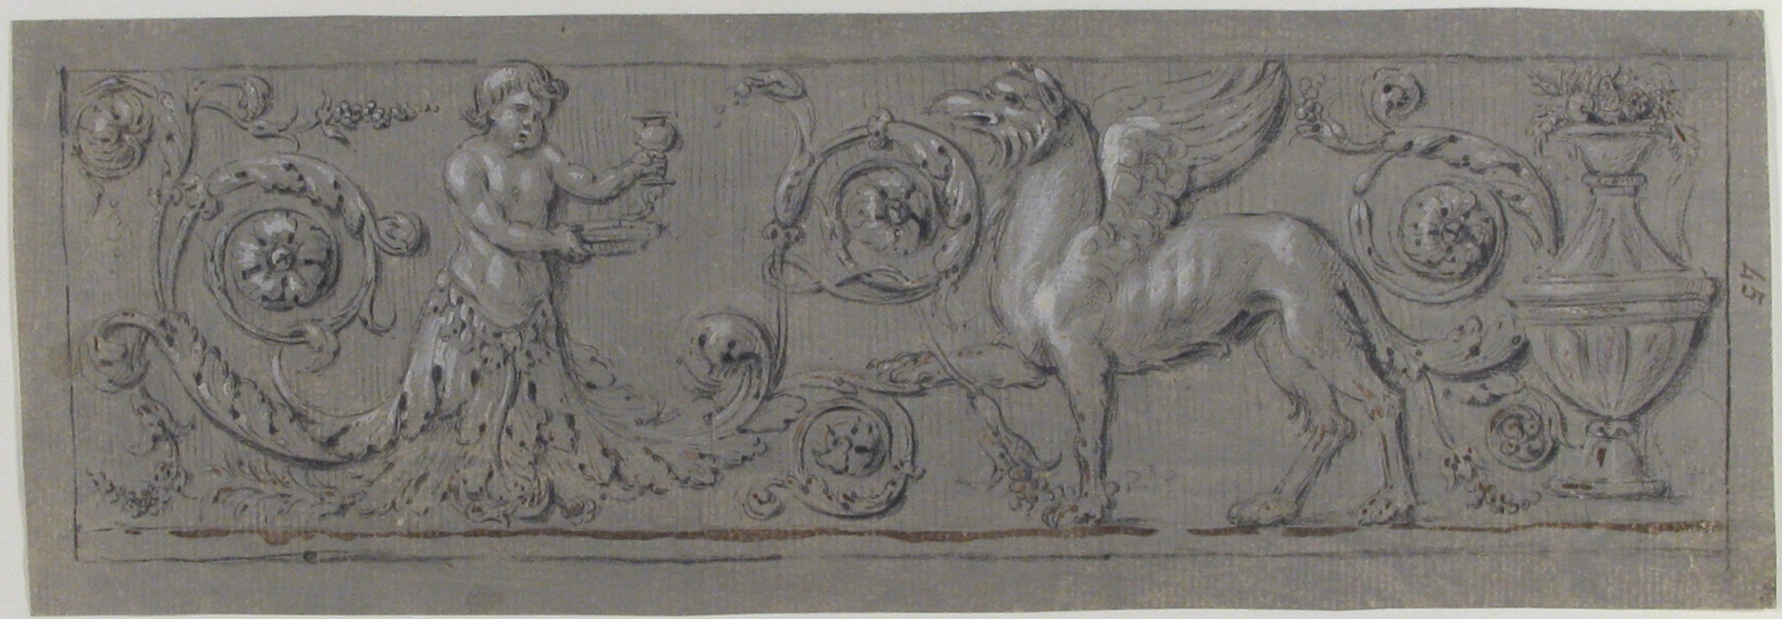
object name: drawing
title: Design for a Decorative Frieze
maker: anonymous, french, 19th century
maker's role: artist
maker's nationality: french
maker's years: 1800-1900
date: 1825-1850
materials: chalk, graphite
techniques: brush, heightening, wash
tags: griffins